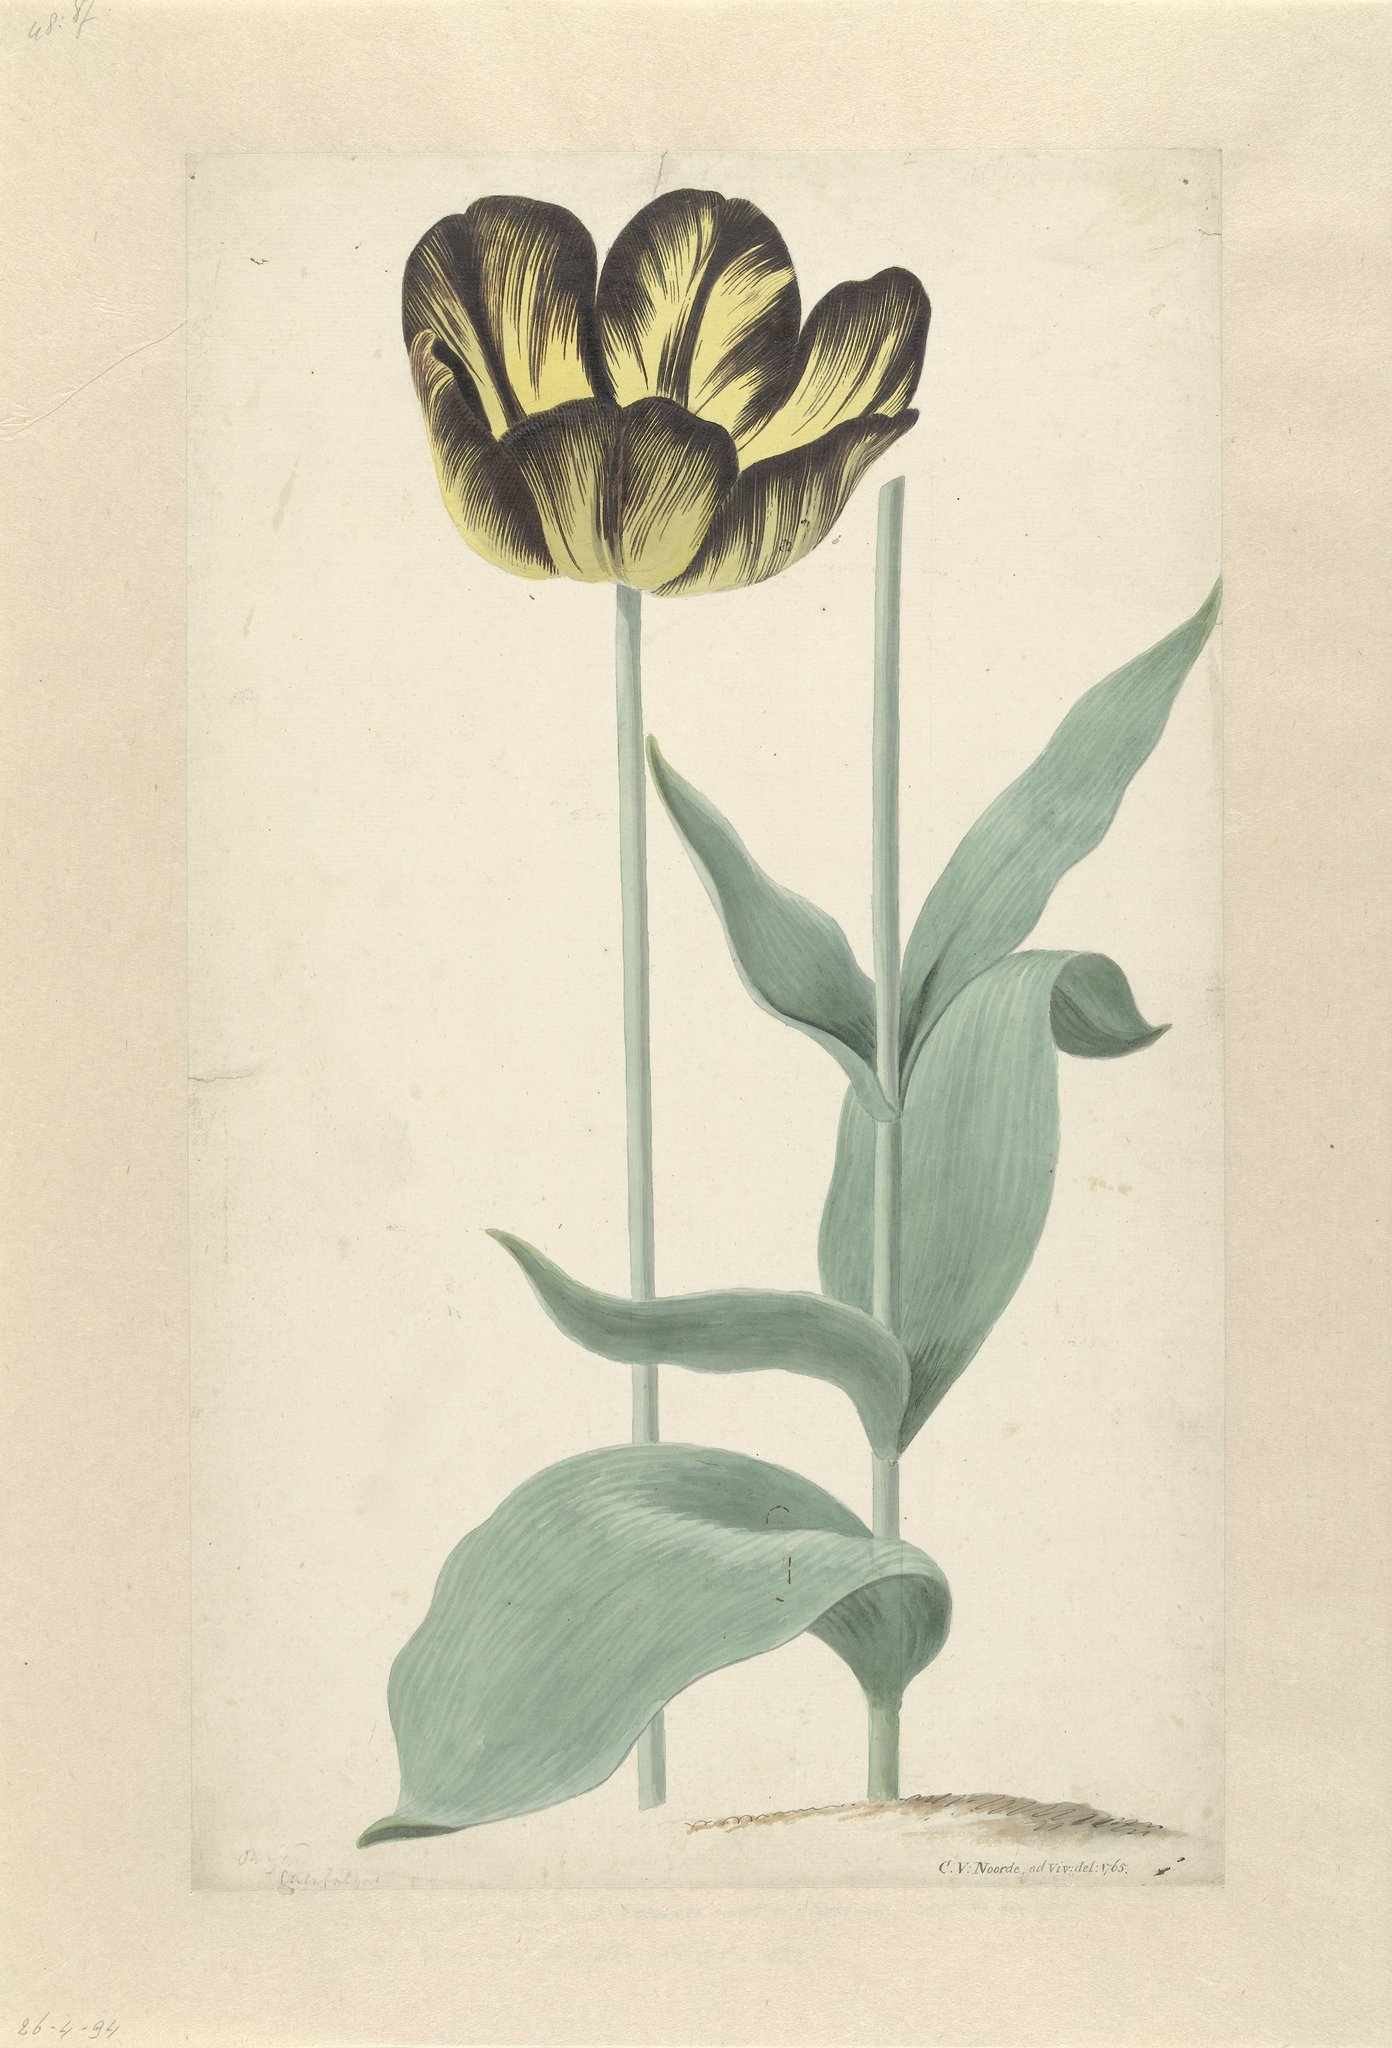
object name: drawing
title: Bizard Catafalque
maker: cornelis van noorde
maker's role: draughtsman, print maker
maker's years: 1731-1795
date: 1765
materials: paper, pencil, watercolor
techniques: brush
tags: flowers: tulip